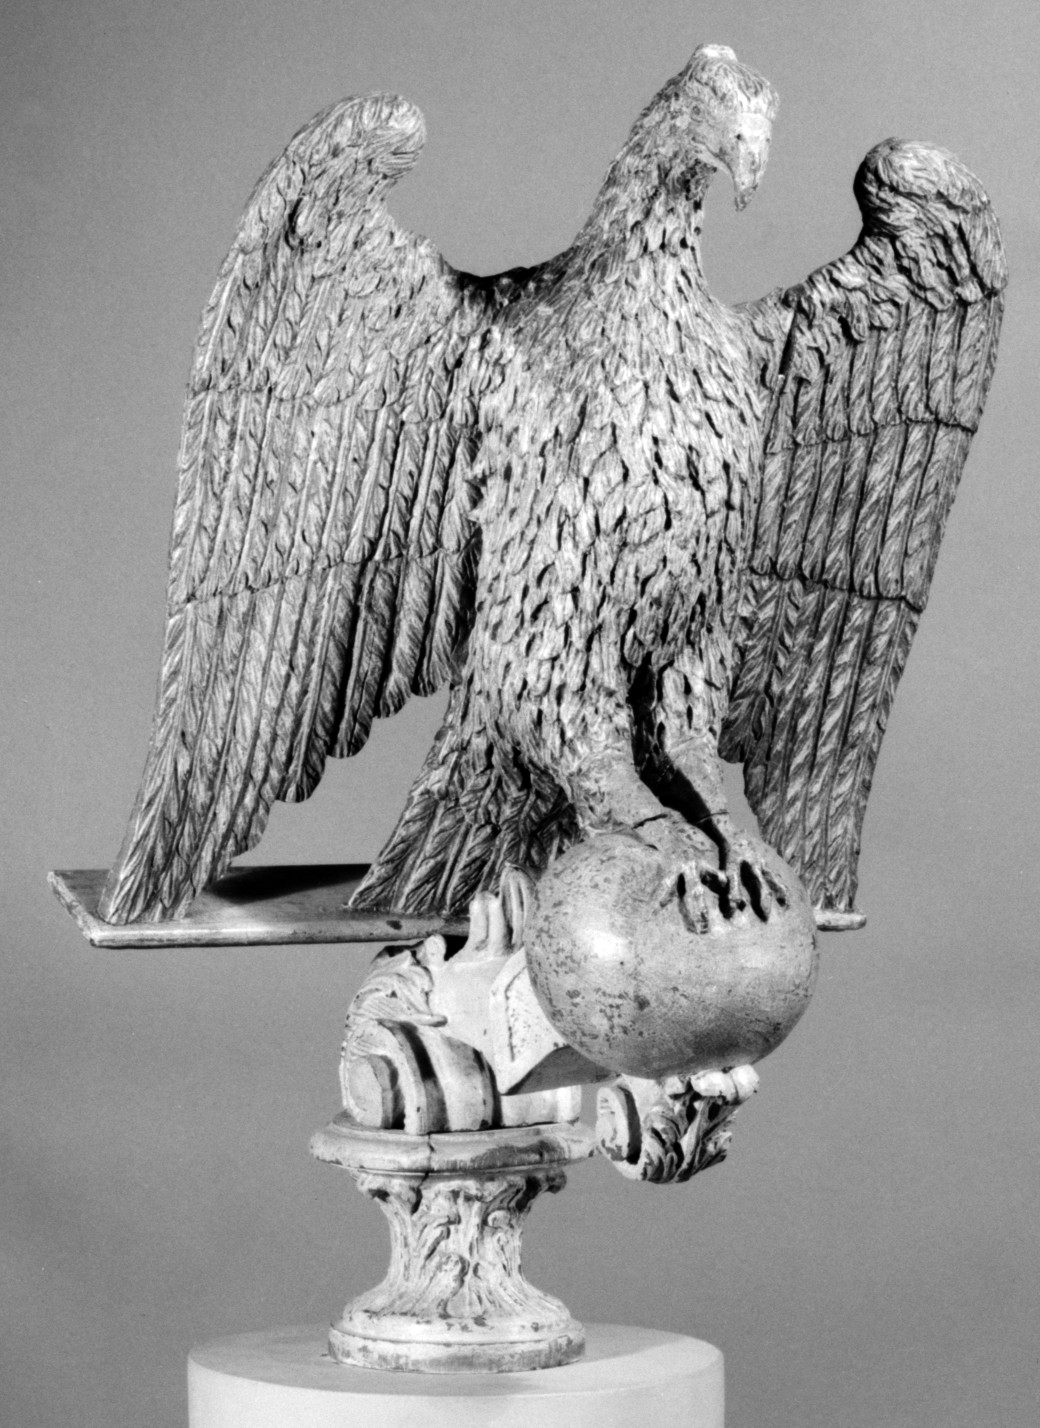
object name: lectern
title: Upper portion of a lectern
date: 1701-1750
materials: wood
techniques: gilding, painting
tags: eagles,furniture